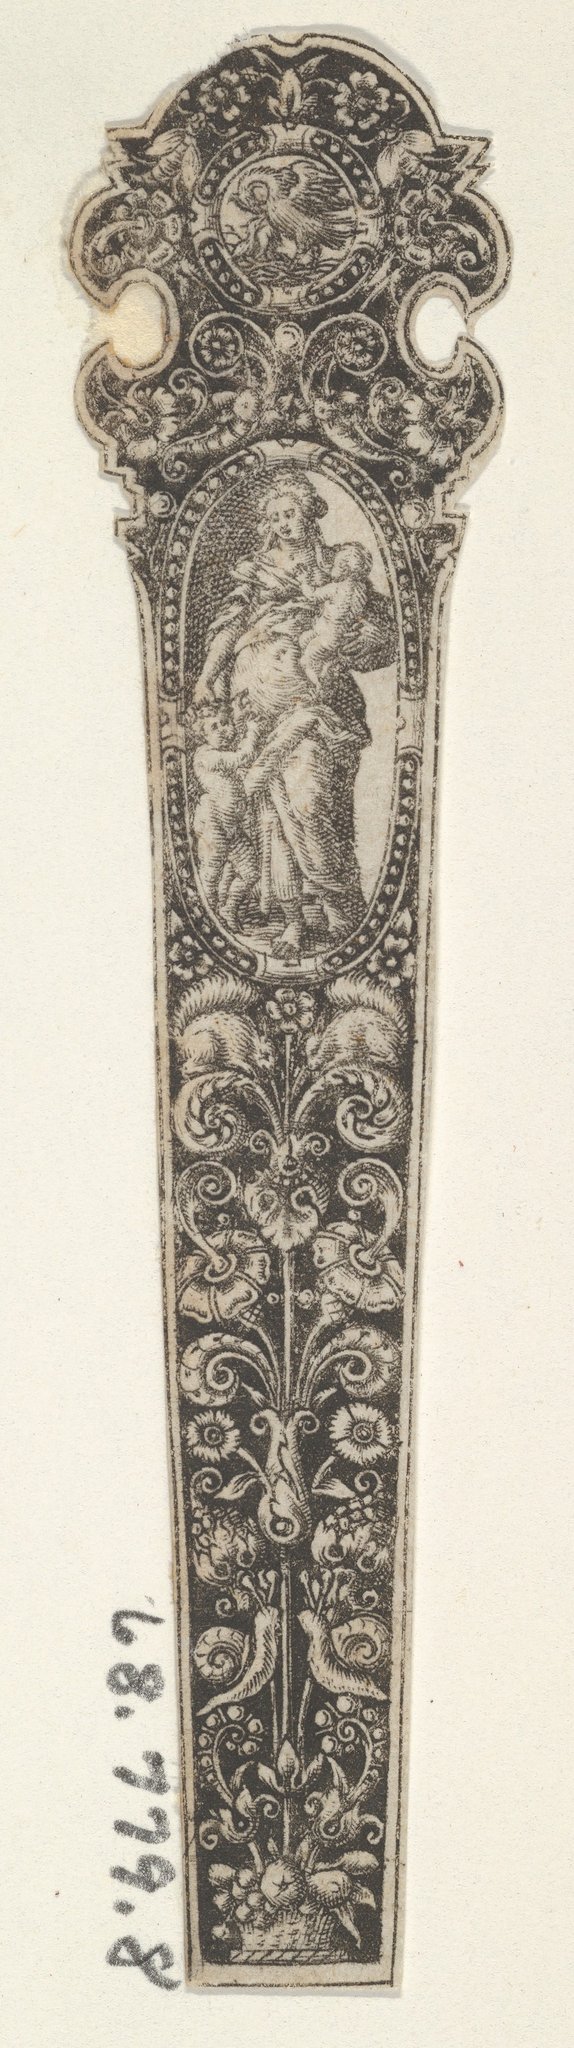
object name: print ornament architecture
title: Design for a Knife Handle with the Personification of Charity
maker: johann theodor de bry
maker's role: artist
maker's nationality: netherlandish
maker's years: 1561-1623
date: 1580-1600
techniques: embroidery, engraving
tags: infants,women,snails,squirrels